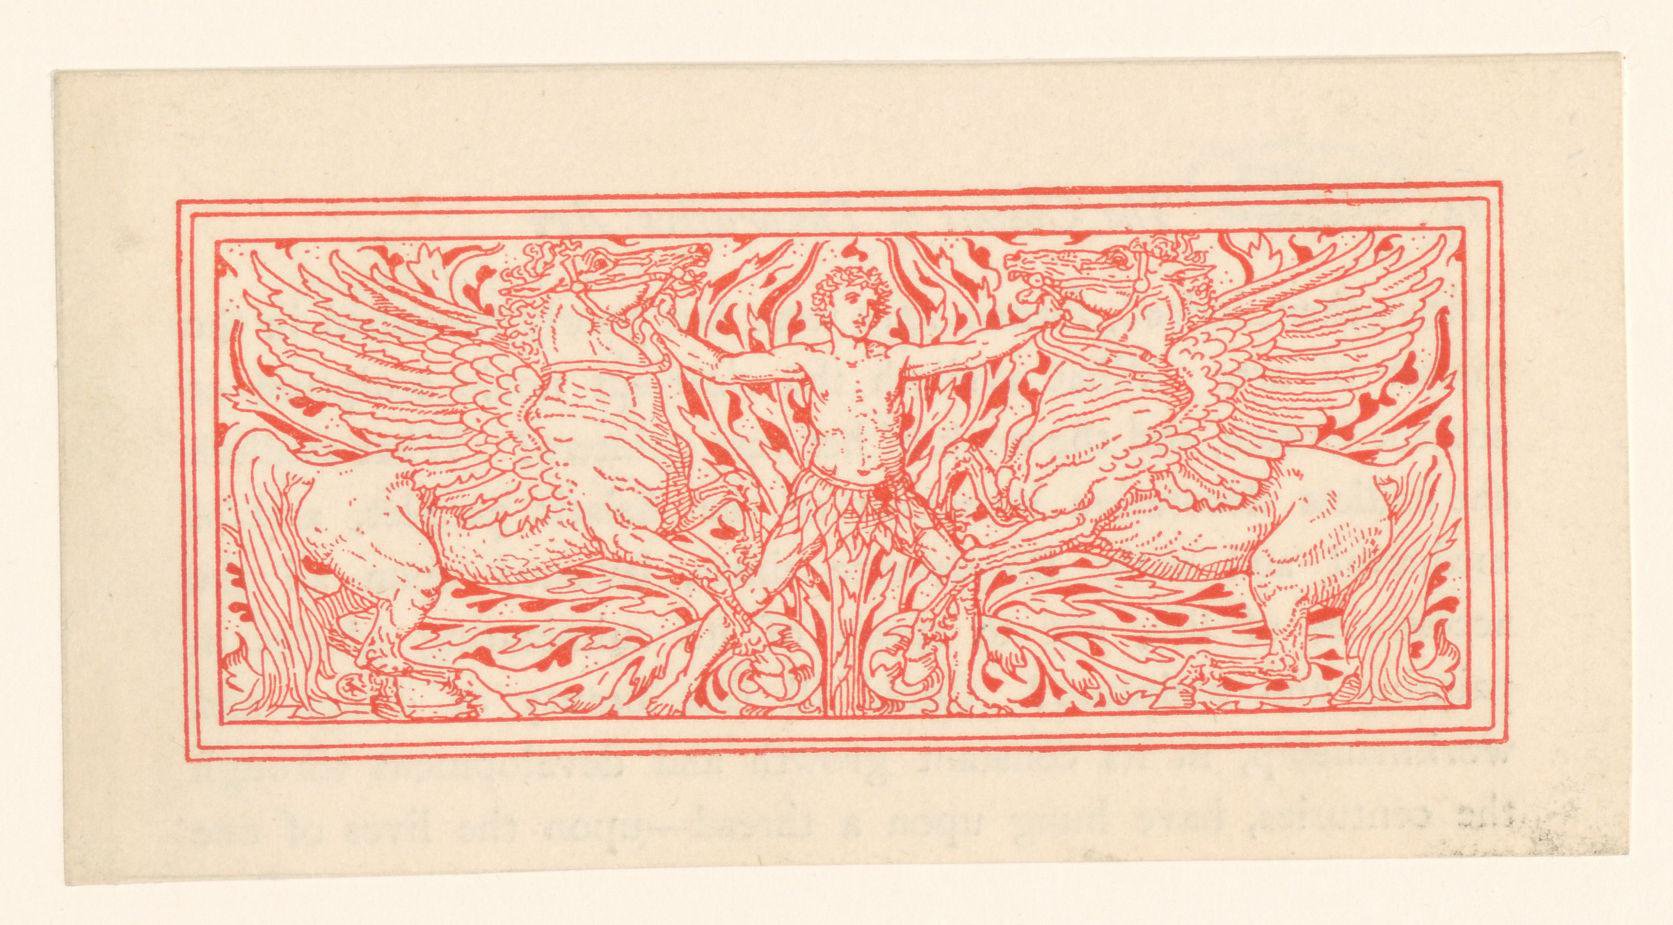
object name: print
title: Man met twee gevleugelde paarden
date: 1892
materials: paper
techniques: letterpress printing, engraving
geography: edinburgh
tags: adult man, fabulous animals ~ hoofed animals: winged horse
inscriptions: collector's mark: Lugt 2228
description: Prent uit: Crane, Walter. The claims of decorative art. Londen: Lawrence & Bullen, 1892, p. 123-124.